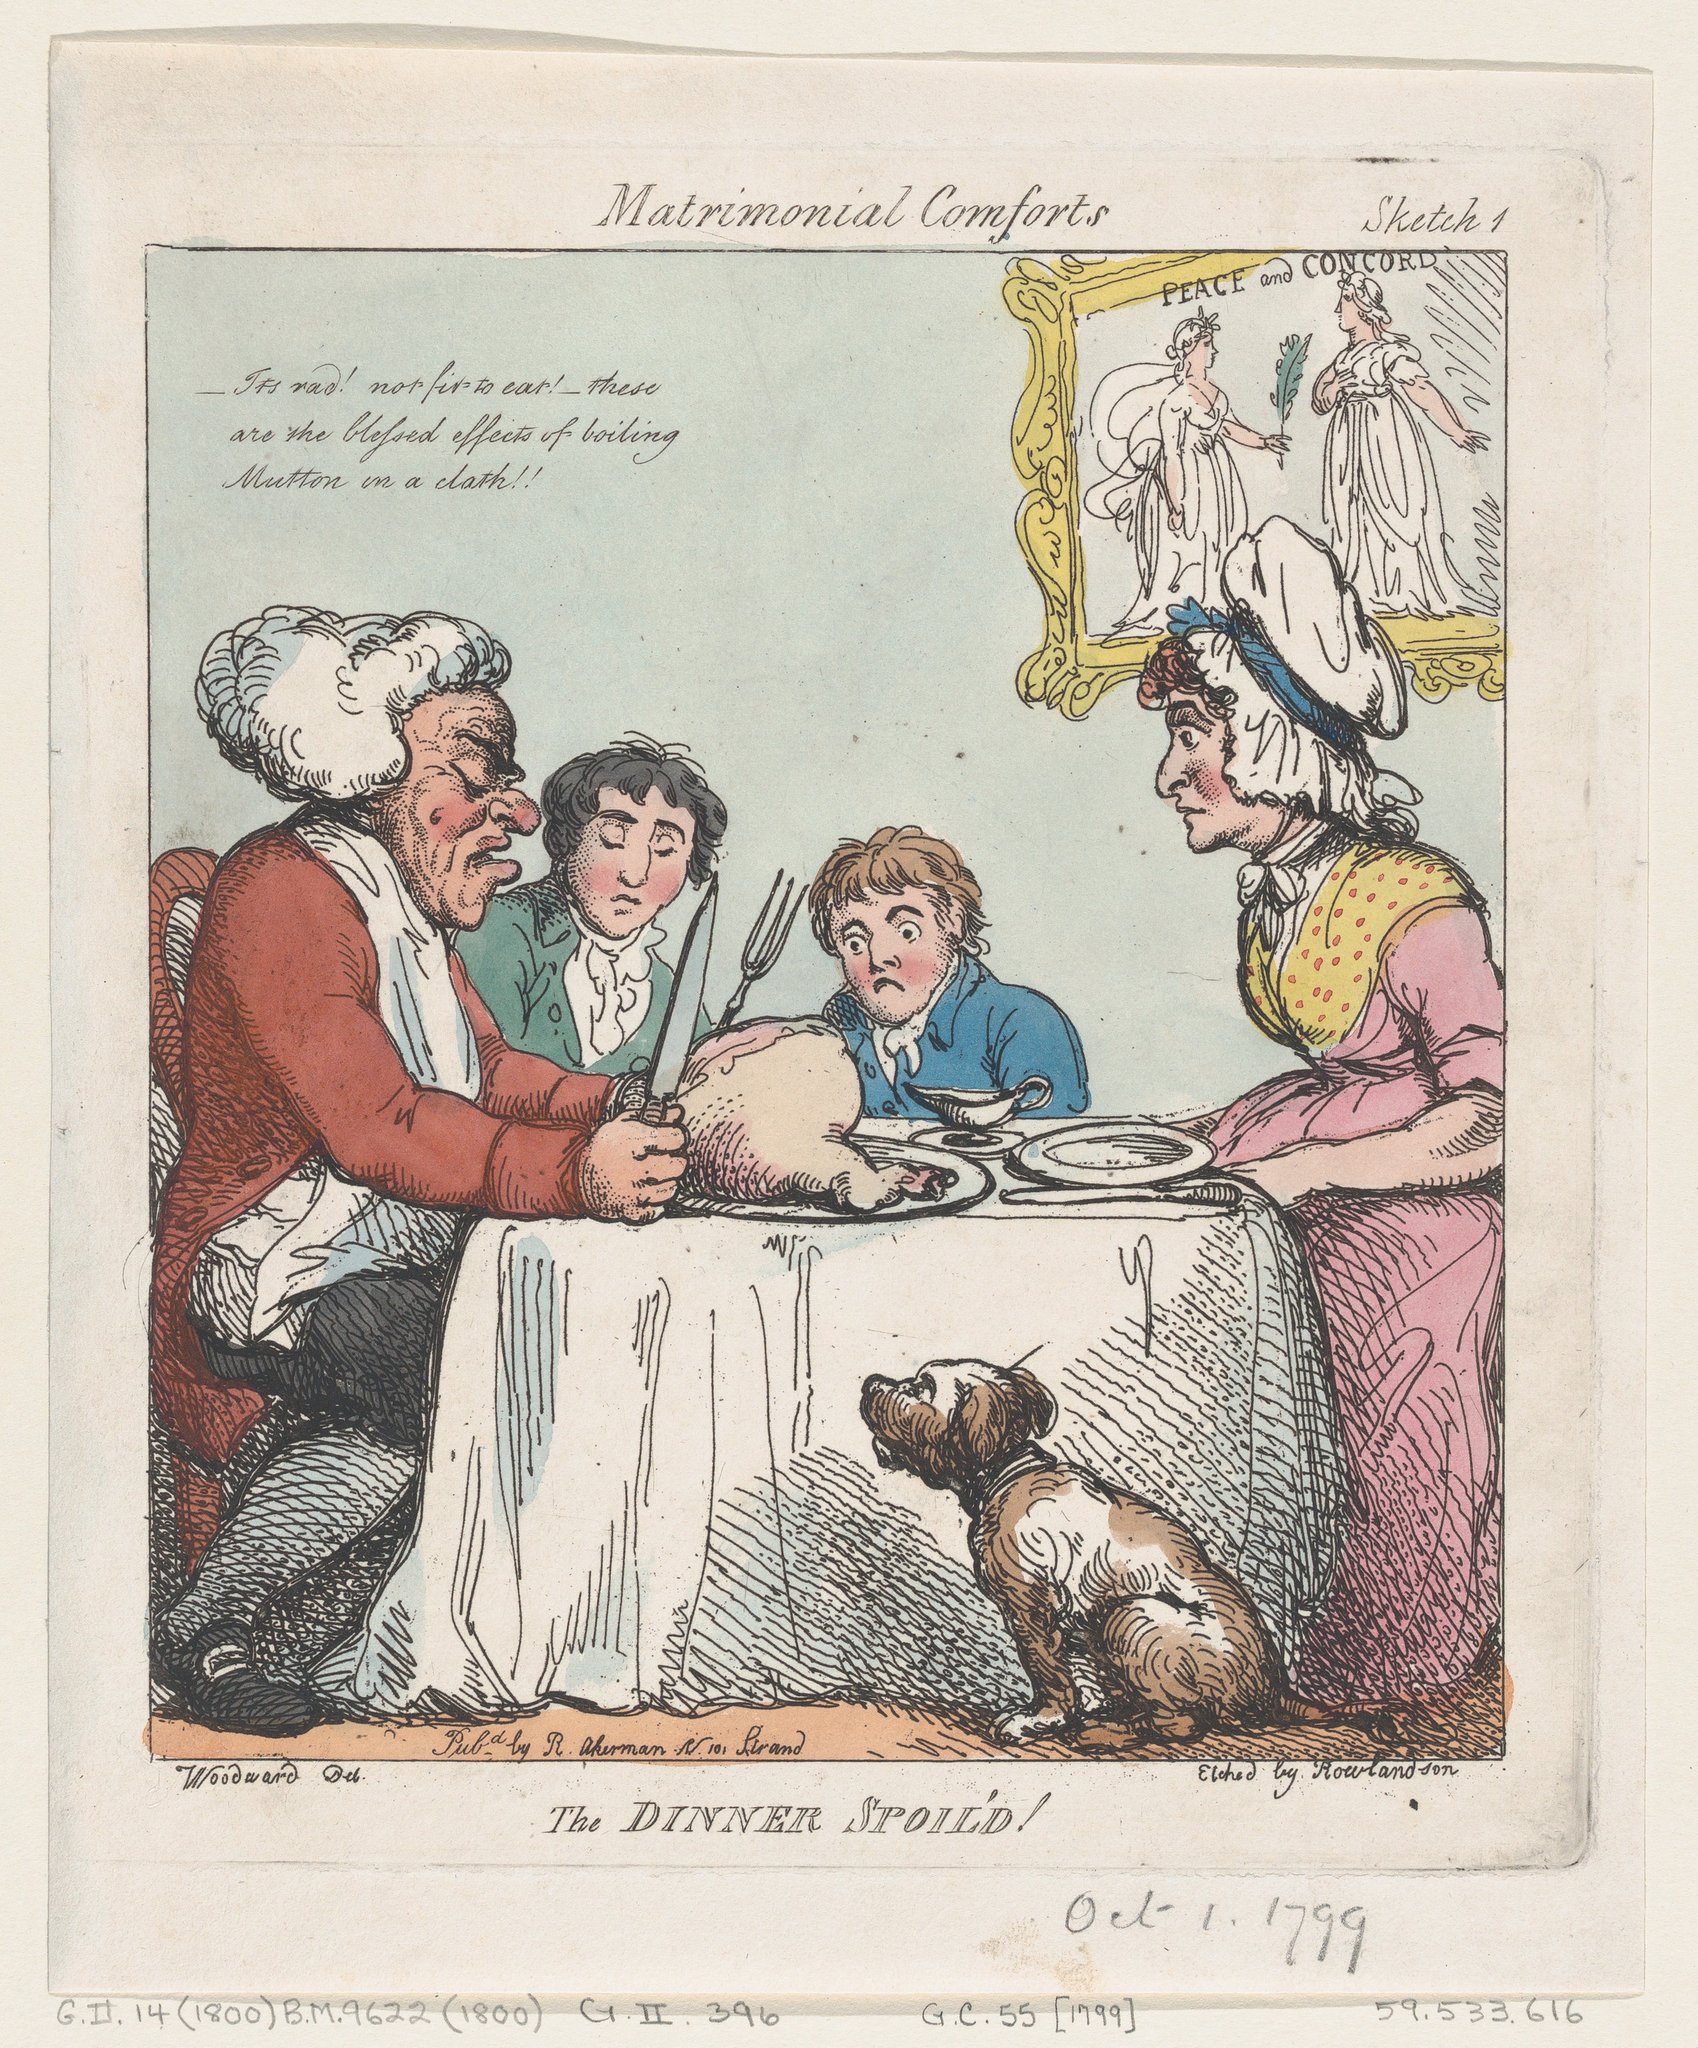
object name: print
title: The Dinner Spoil'd!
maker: thomas rowlandson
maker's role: artist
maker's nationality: british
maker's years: 1757-1827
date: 1800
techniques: etching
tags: boys,men,women,dining